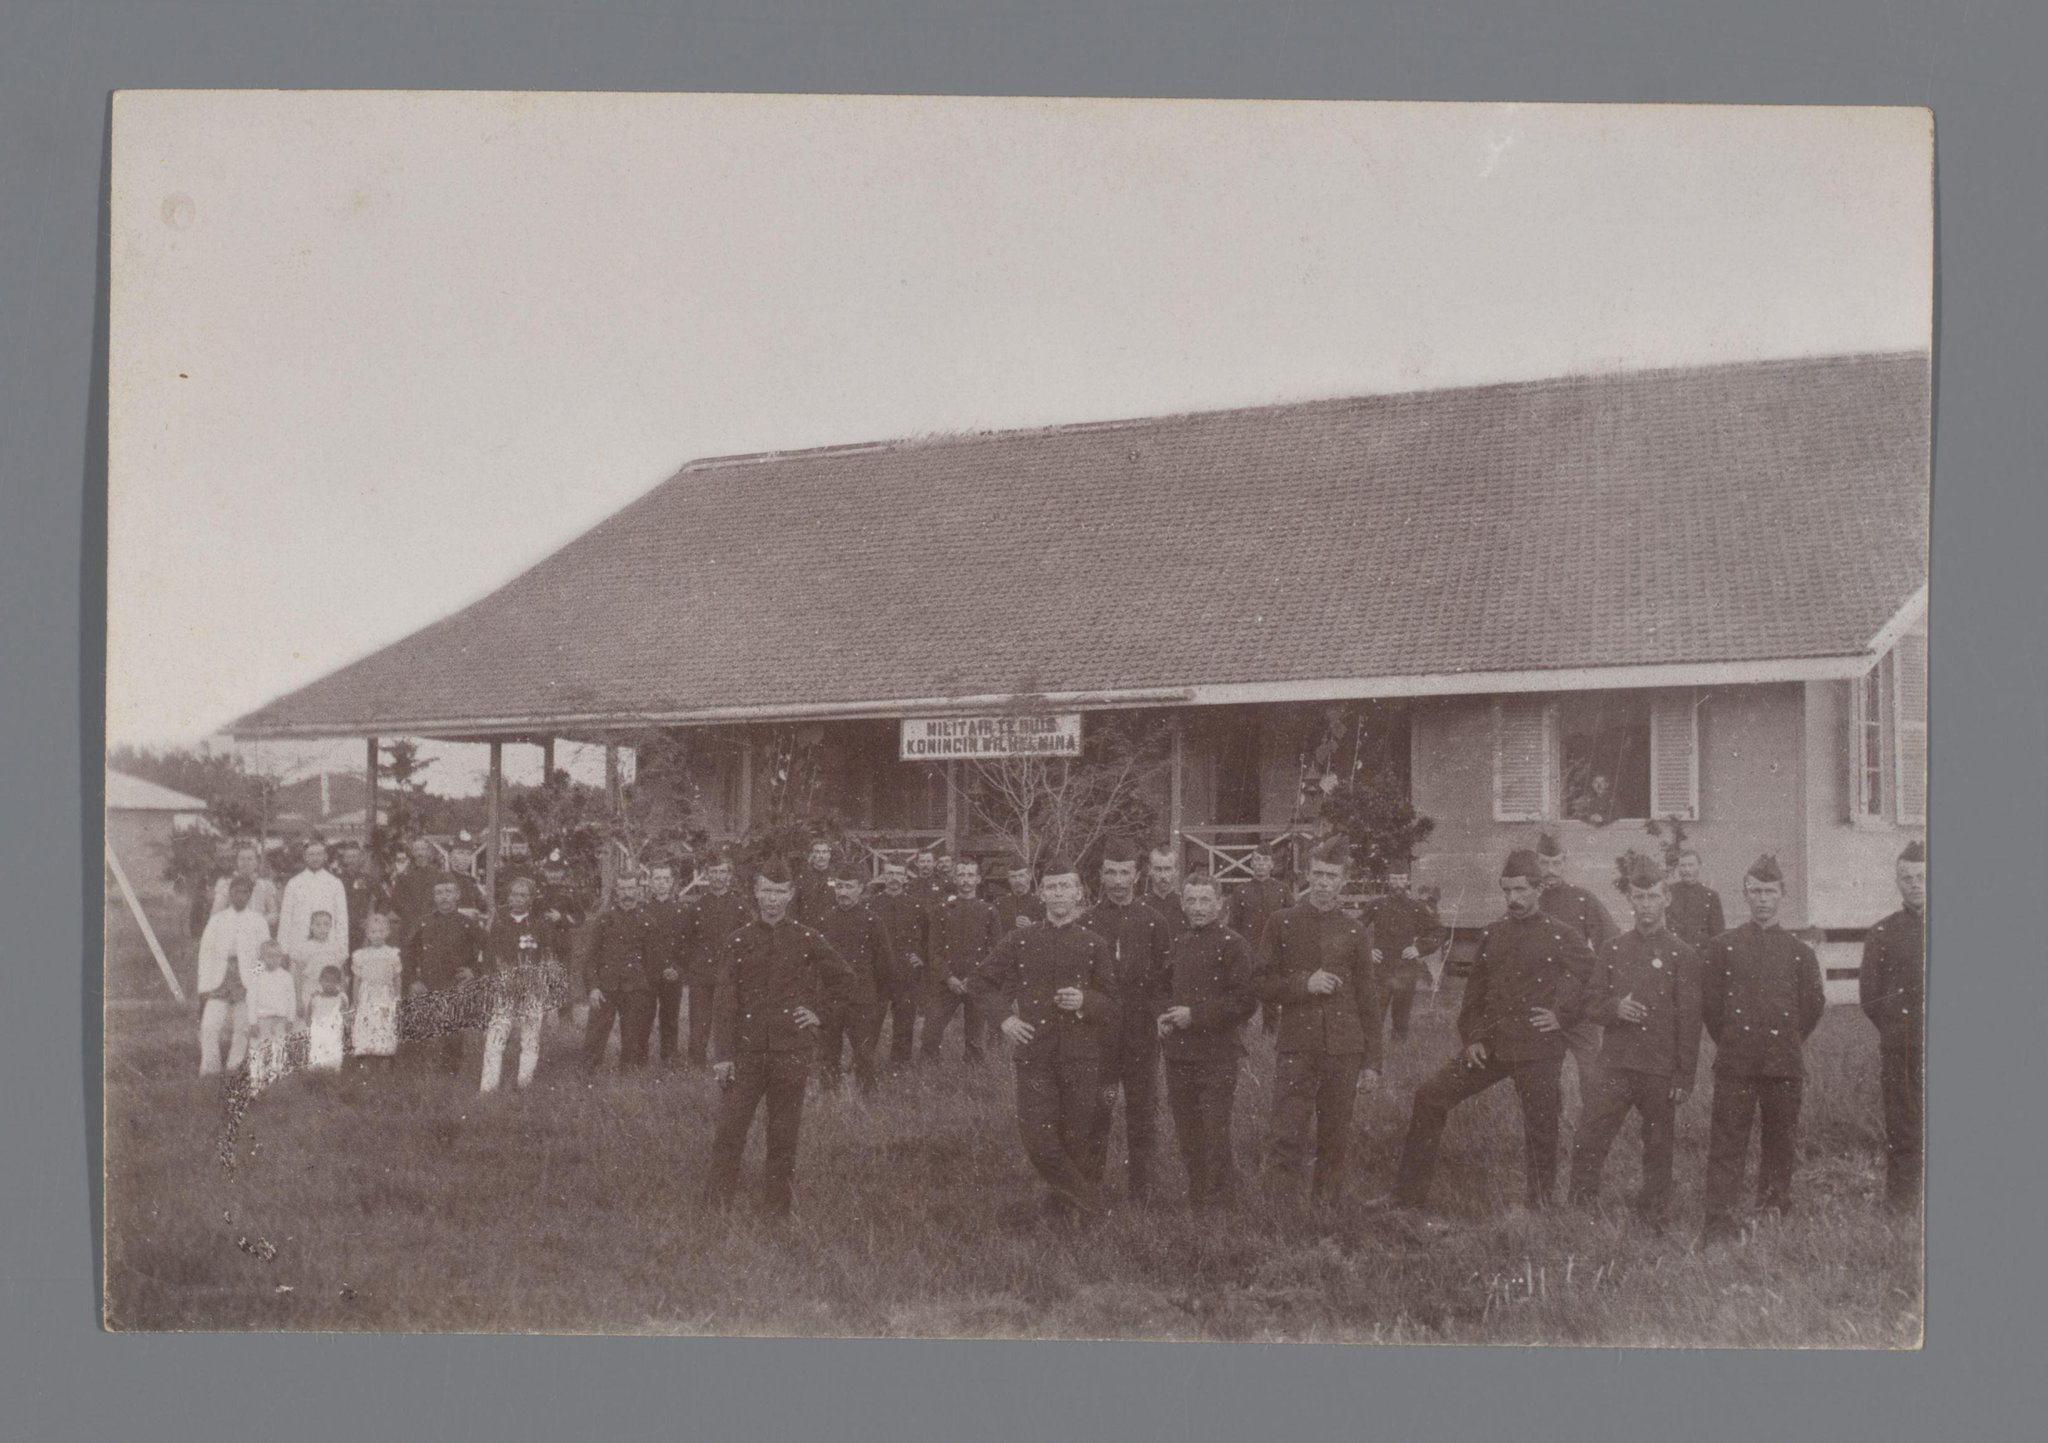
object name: photograph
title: Militair Tehuis Koningin Wilhelmina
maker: Anonymous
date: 1900-1940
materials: photographic support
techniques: collodion silver print, gelatin silver print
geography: sumatra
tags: sumatra, dutch east indies, the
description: Soldaten en personeel poserend buiten voor het Militair Tehuis Koningin Wilhelmina. Onderdeel van een groep van 14 losse foto's genomen op Midden- en Zuid-Sumatra in de periode ca. 1900-1940.